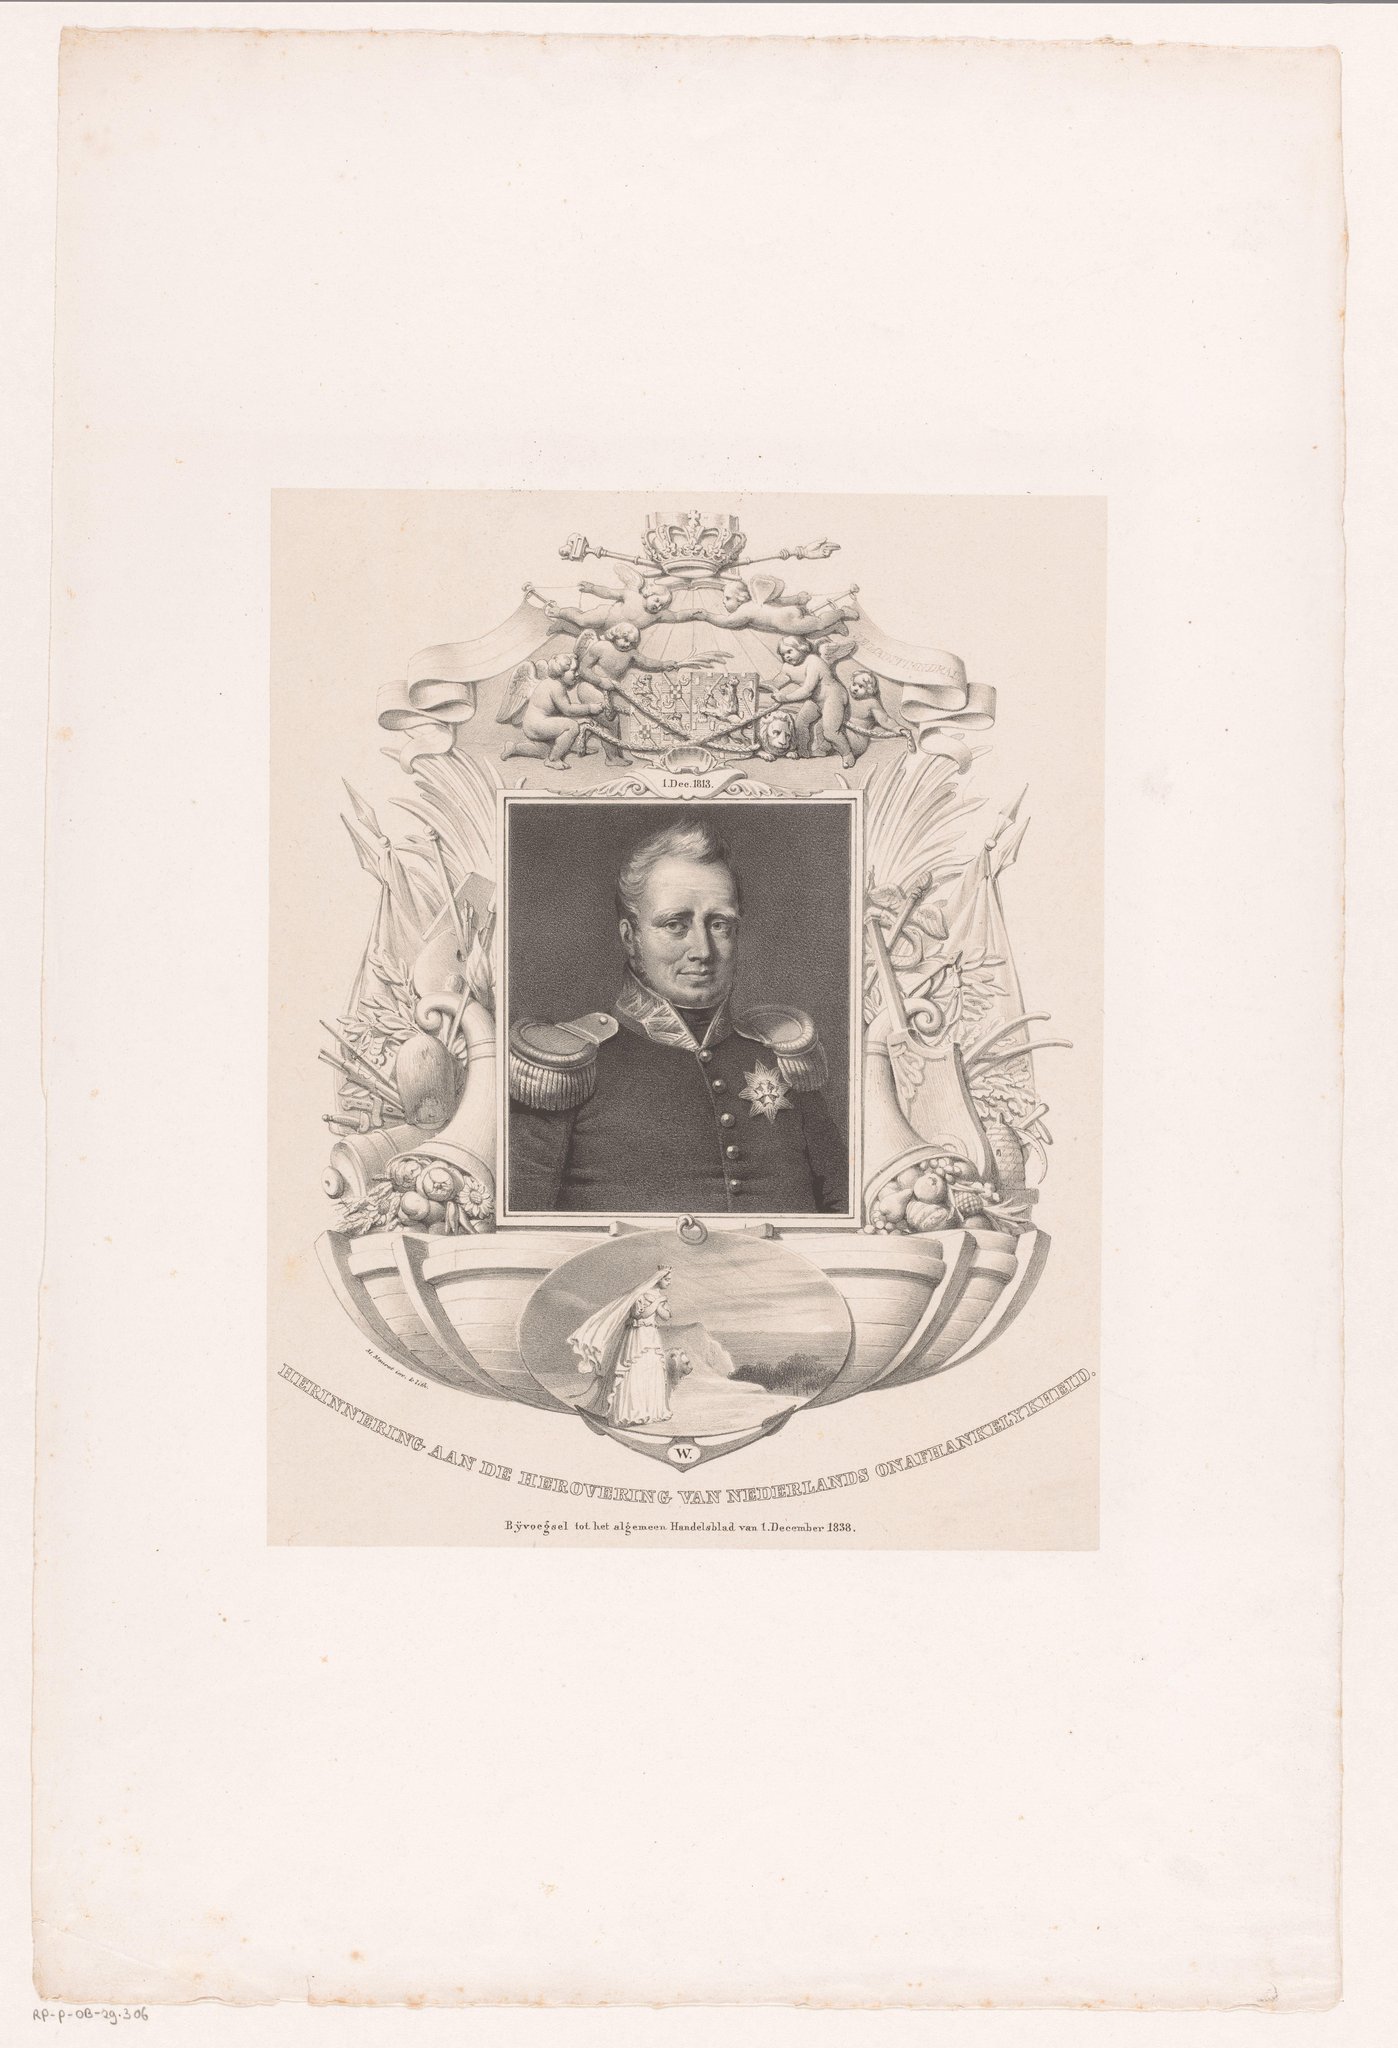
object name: print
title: Portret van Koning Willem I in ornamentlijst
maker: michel mourot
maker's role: draughtsman, print maker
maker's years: 1803-1847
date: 1838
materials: paper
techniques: lithograph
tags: the hague, berlin, william i of the netherlands, 'cornucopia', horn of plenty, personifications of countries, nations, states, districts, etc., parts of ship's exterior: bow, historical persons (+ (full) bust portrait)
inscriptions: collector's mark: Lugt 2228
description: Boven het portret wapenschilden, putti en een kroon. Links en rechts van het portret hoornen des overvloed en attributen die verwijzen naar handel, wetenschap en kunsten. Onderin vier voorstevens van schepen met in het midden de Nederlandse Maagd met leeuw die in afwachting van Willem I uitkijkt over de Noordzee.